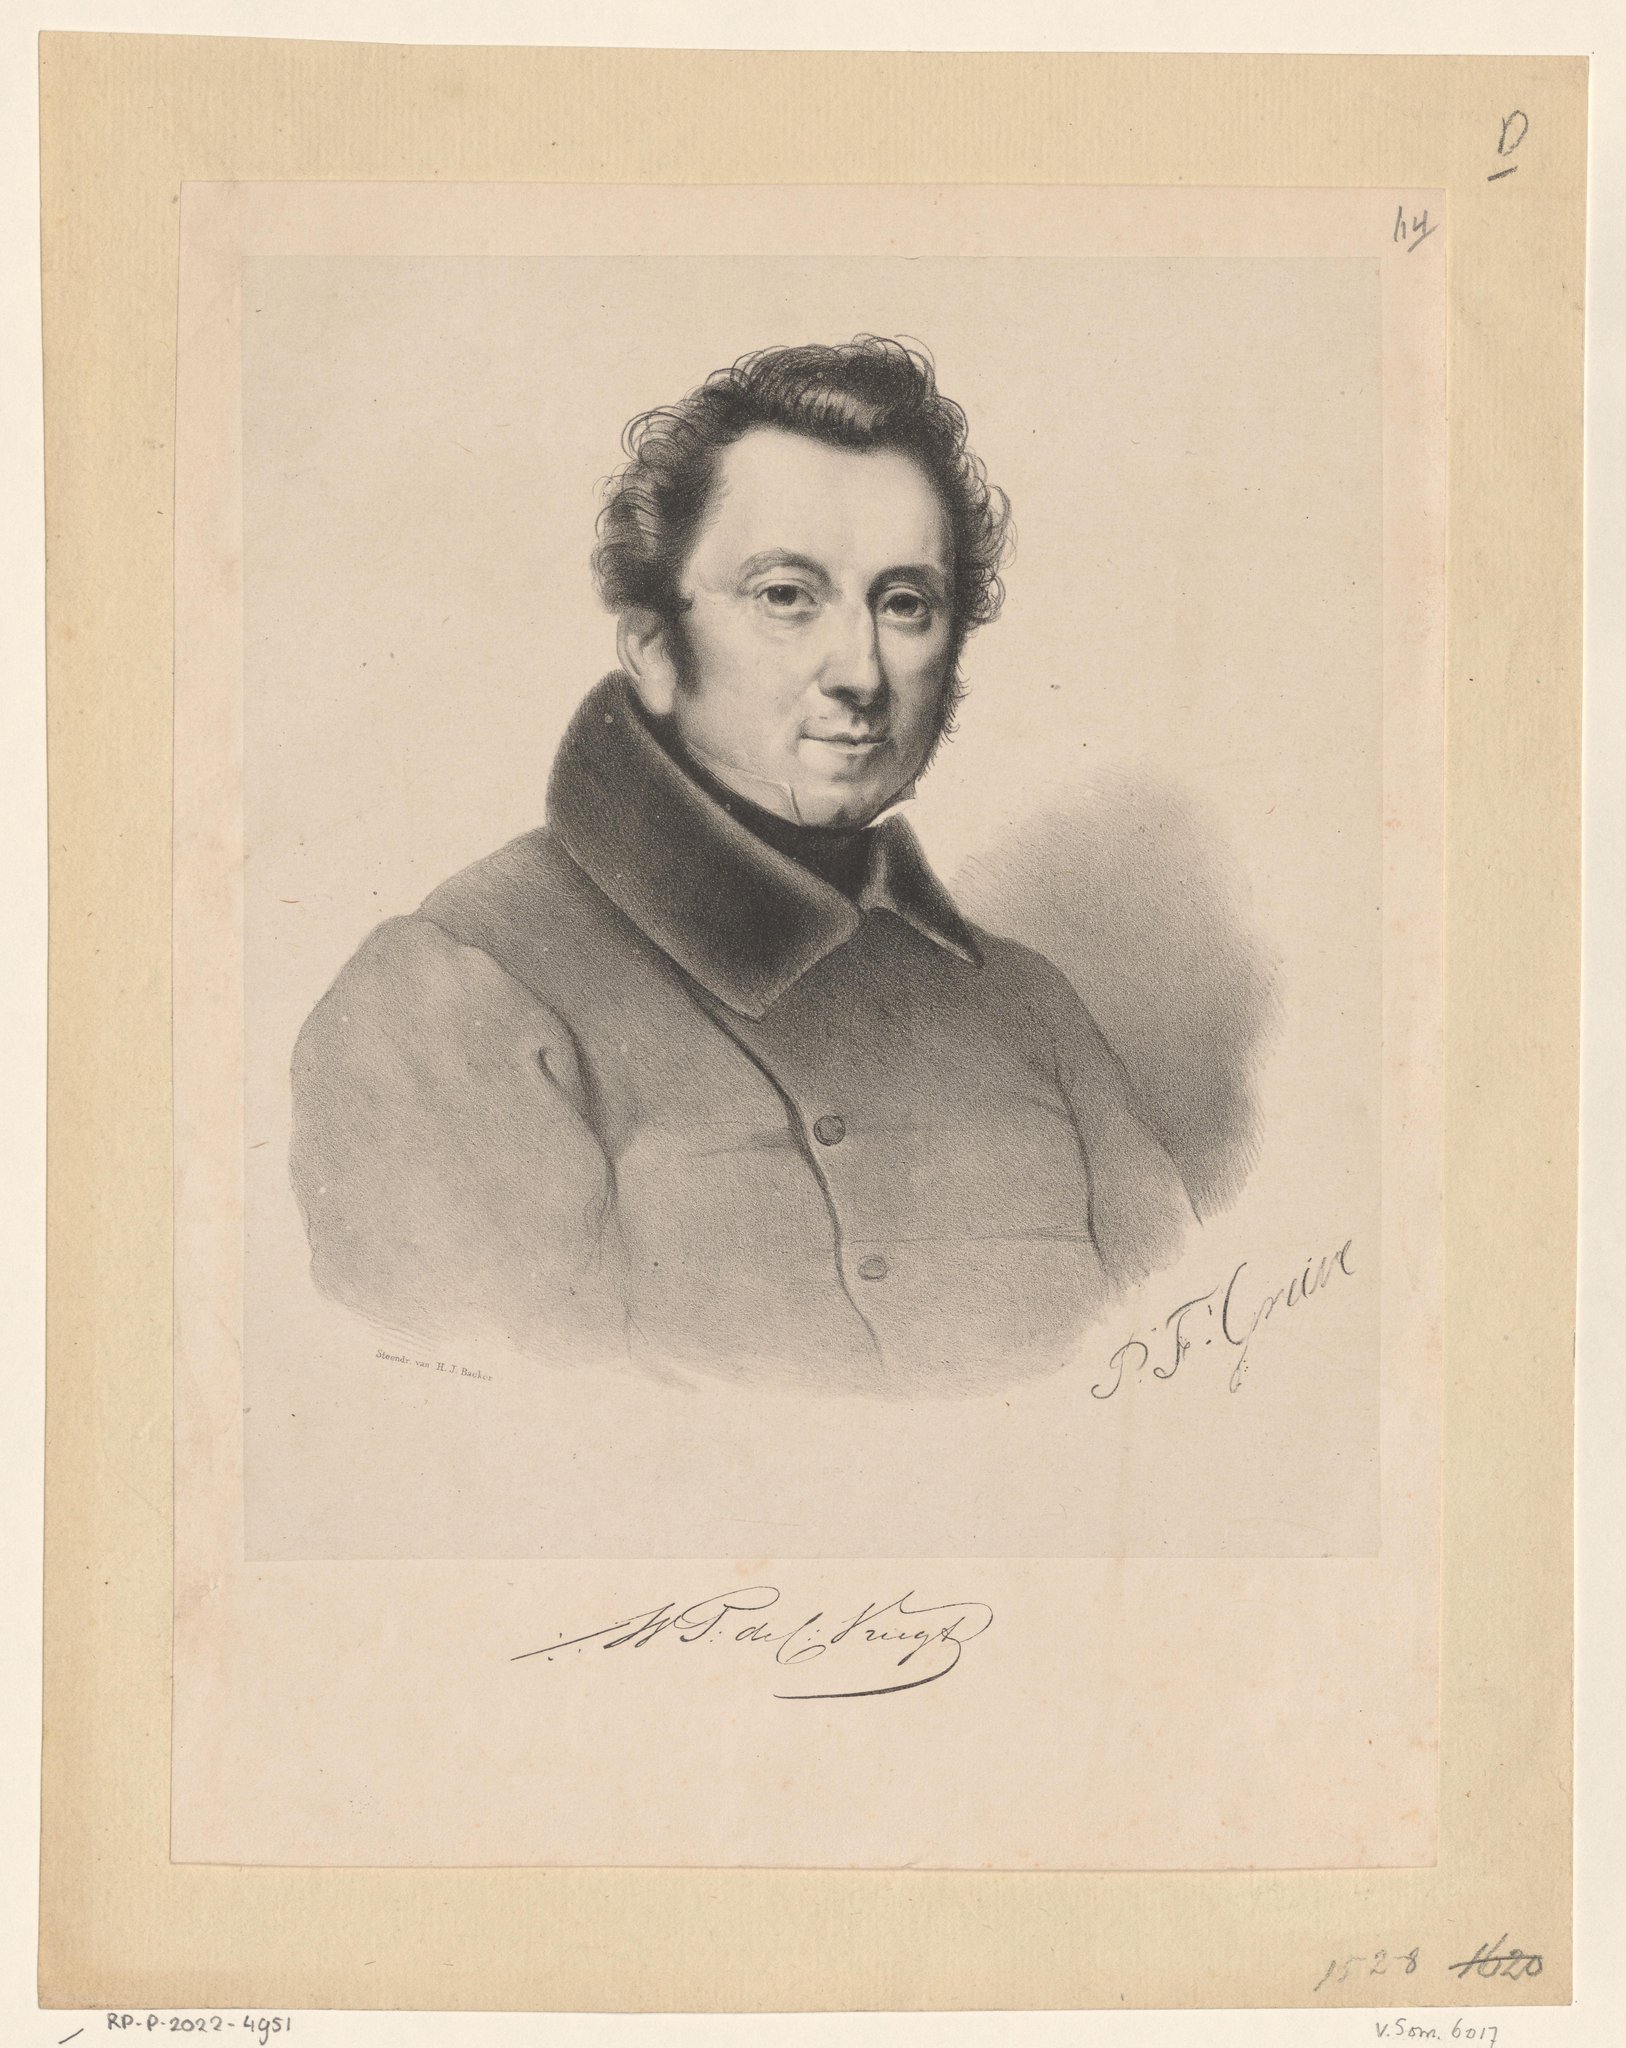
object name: print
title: Portret van Willem Pasques de Chavonnes Vrugt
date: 1830-1845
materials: paper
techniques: lithograph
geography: dordrecht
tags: willem pasques de chavonnes vrugt, male singer, historical persons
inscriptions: collector's mark: Lugt 2228